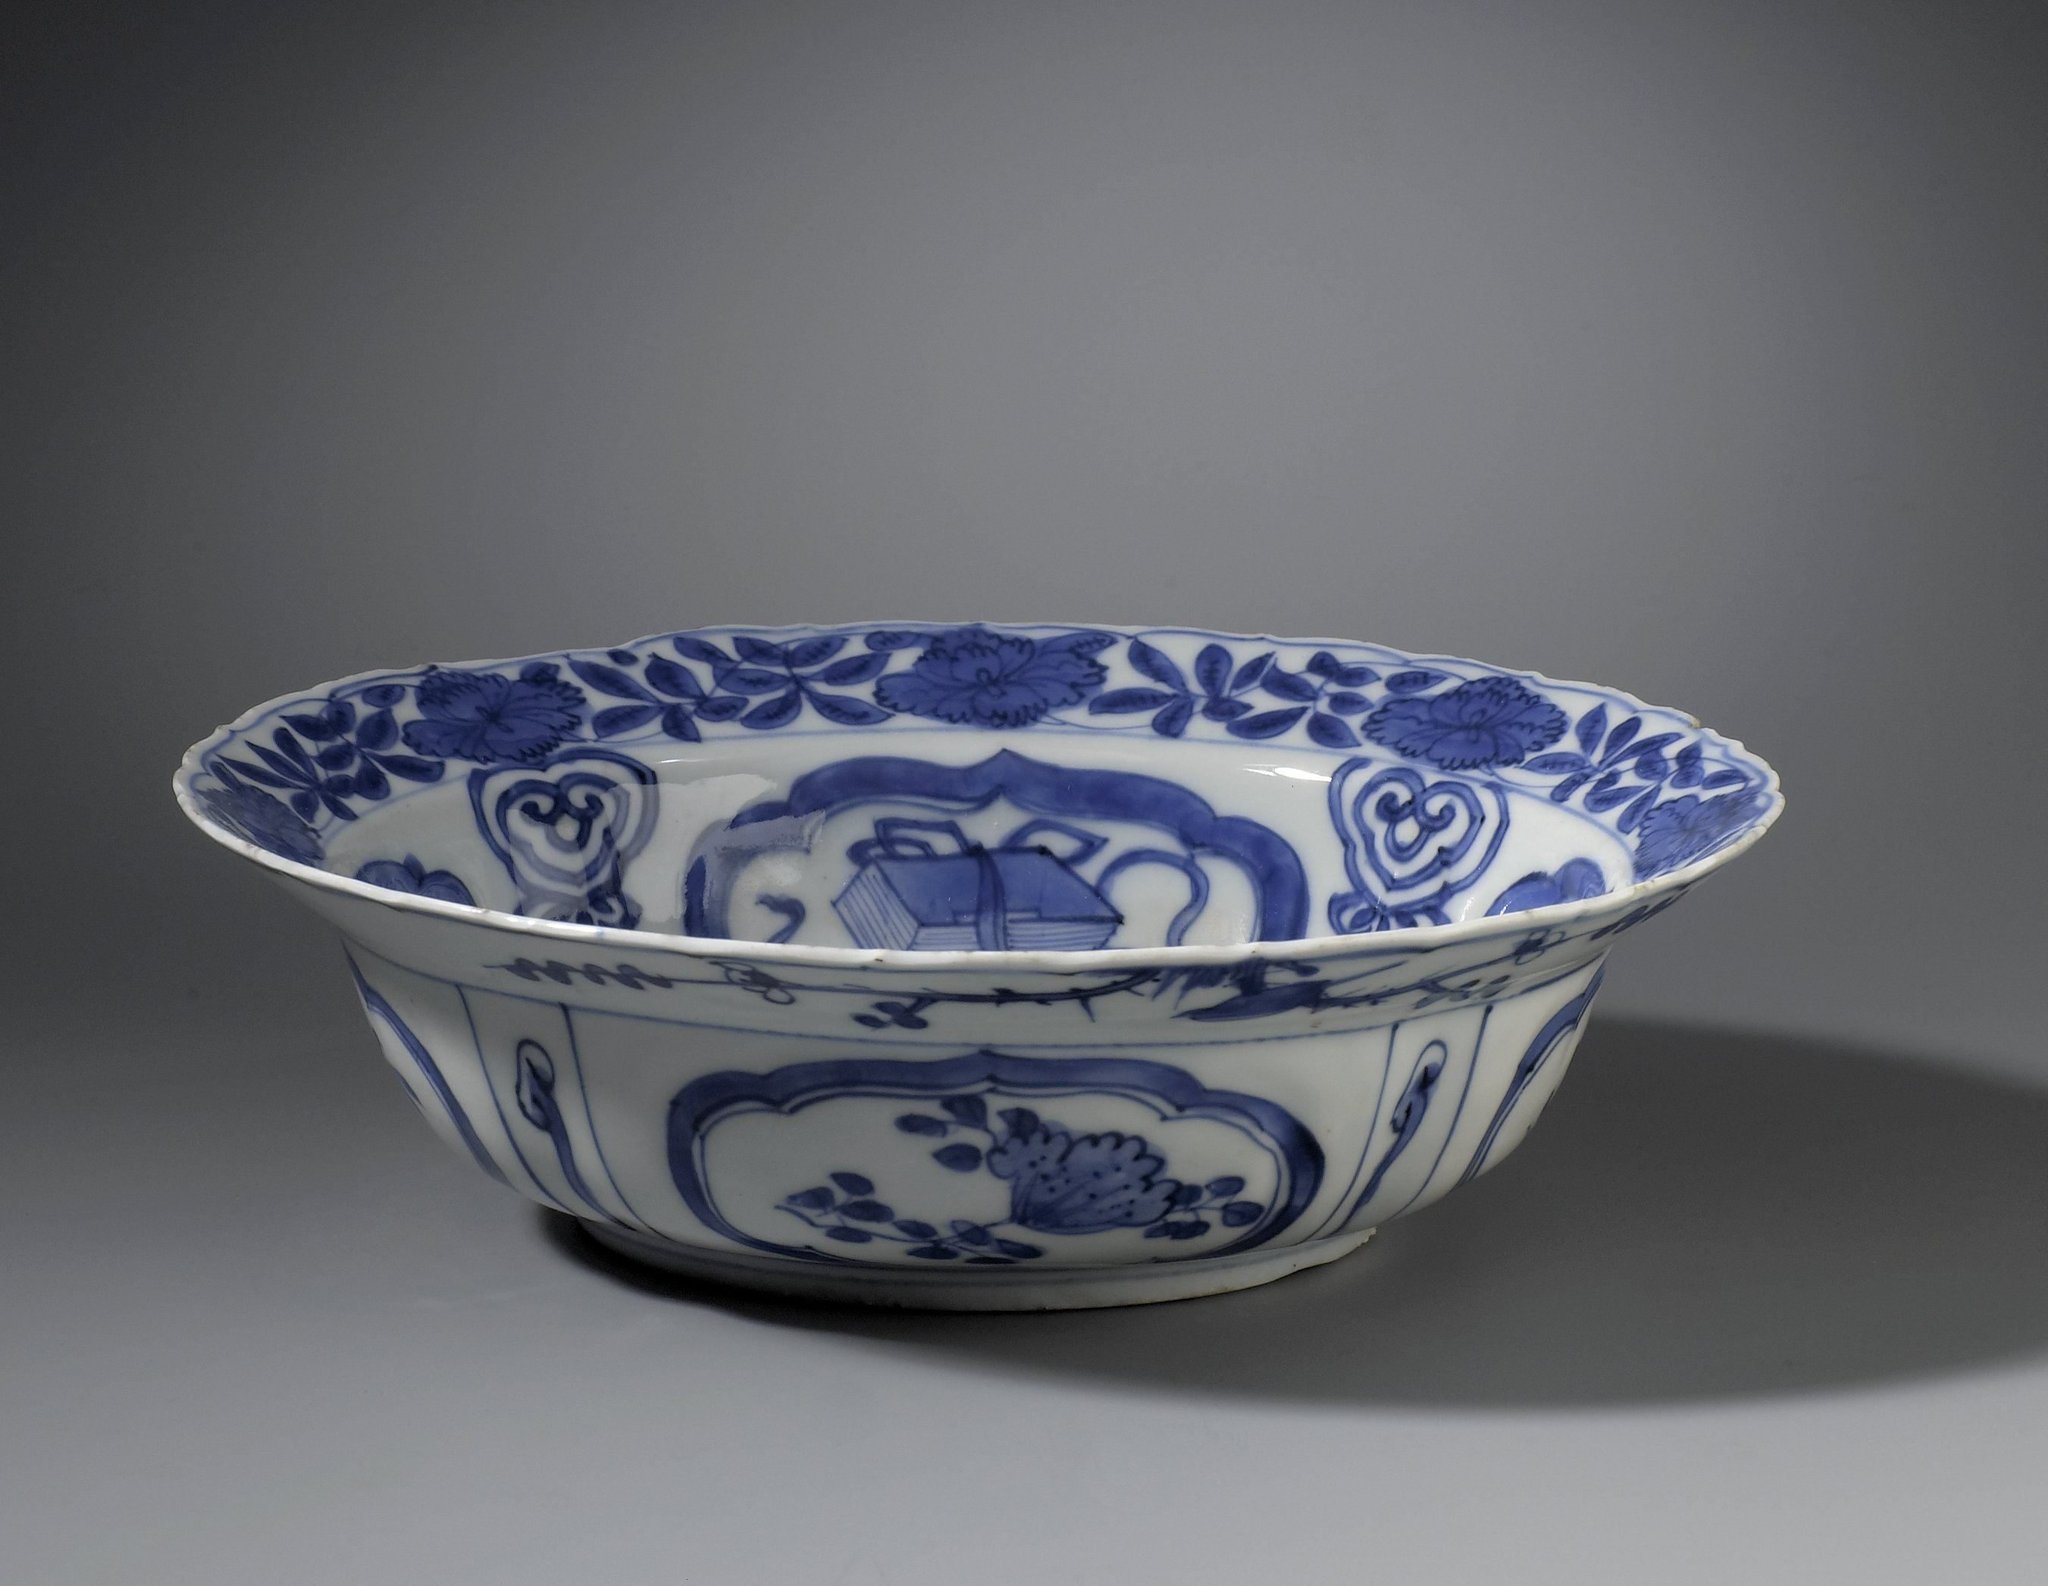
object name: klapmuts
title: Klapmuts bowl with birds on a rock, symbolic objects and flower sprays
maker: Anonymous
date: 1600-1624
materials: cobalt, glaze, paint, porcelain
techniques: firing, turning, vitrification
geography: china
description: Klapmutskom gedecoreerd in onderglazuur blauw. Twee vogels bij een rots en bloeiende planten in het plat. Op de zijden vakken met bloeiende planten en geluksymbolen; bloemtakken op de rand.